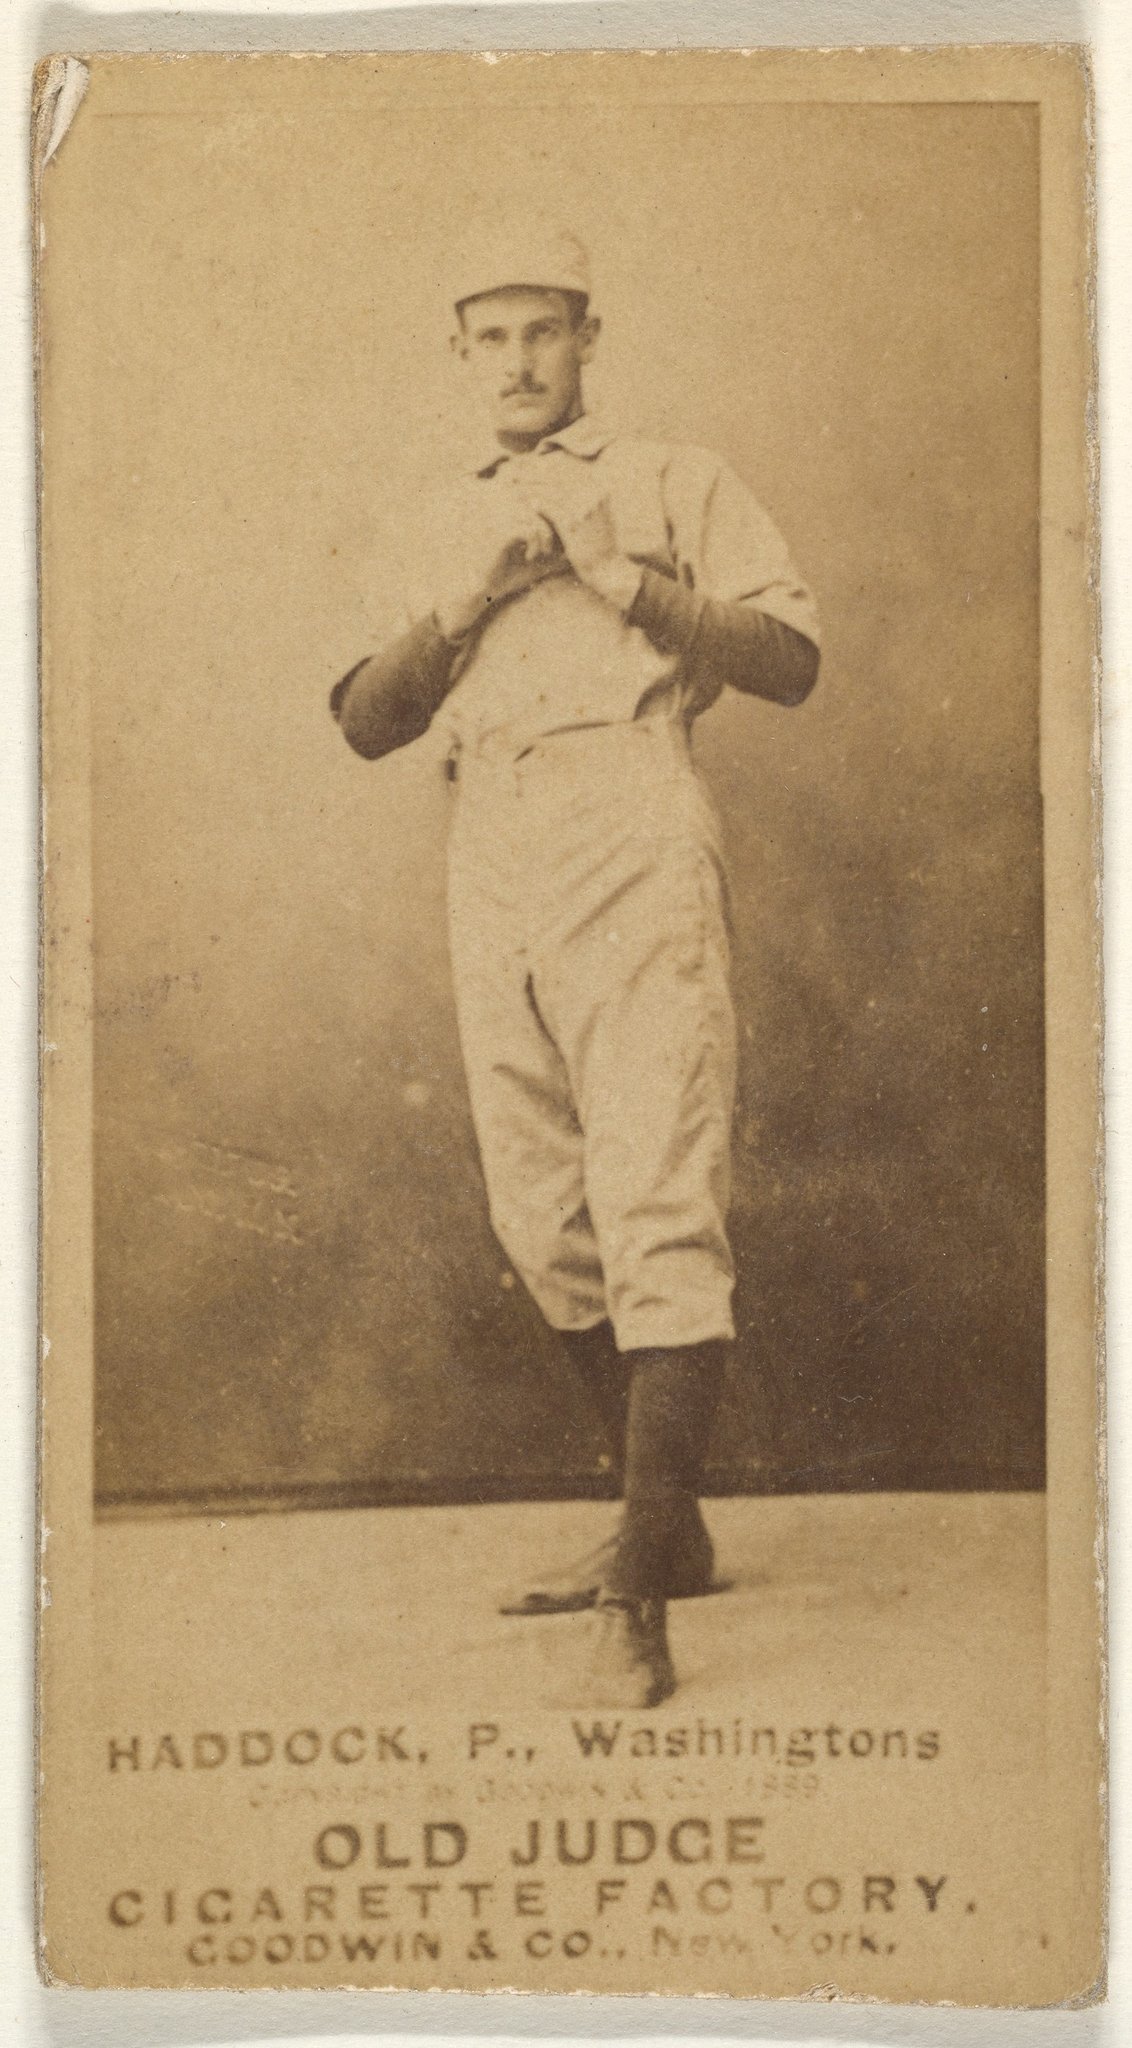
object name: baseball card, photograph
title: George Silas Haddock, Pitcher, Washington Nationals, from the Old Judge series (N172) for Old Judge Cigarettes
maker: goodwin & company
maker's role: publisher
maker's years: 1850-1950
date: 1889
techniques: albumen silver print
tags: men,portraits,baseball,athletes